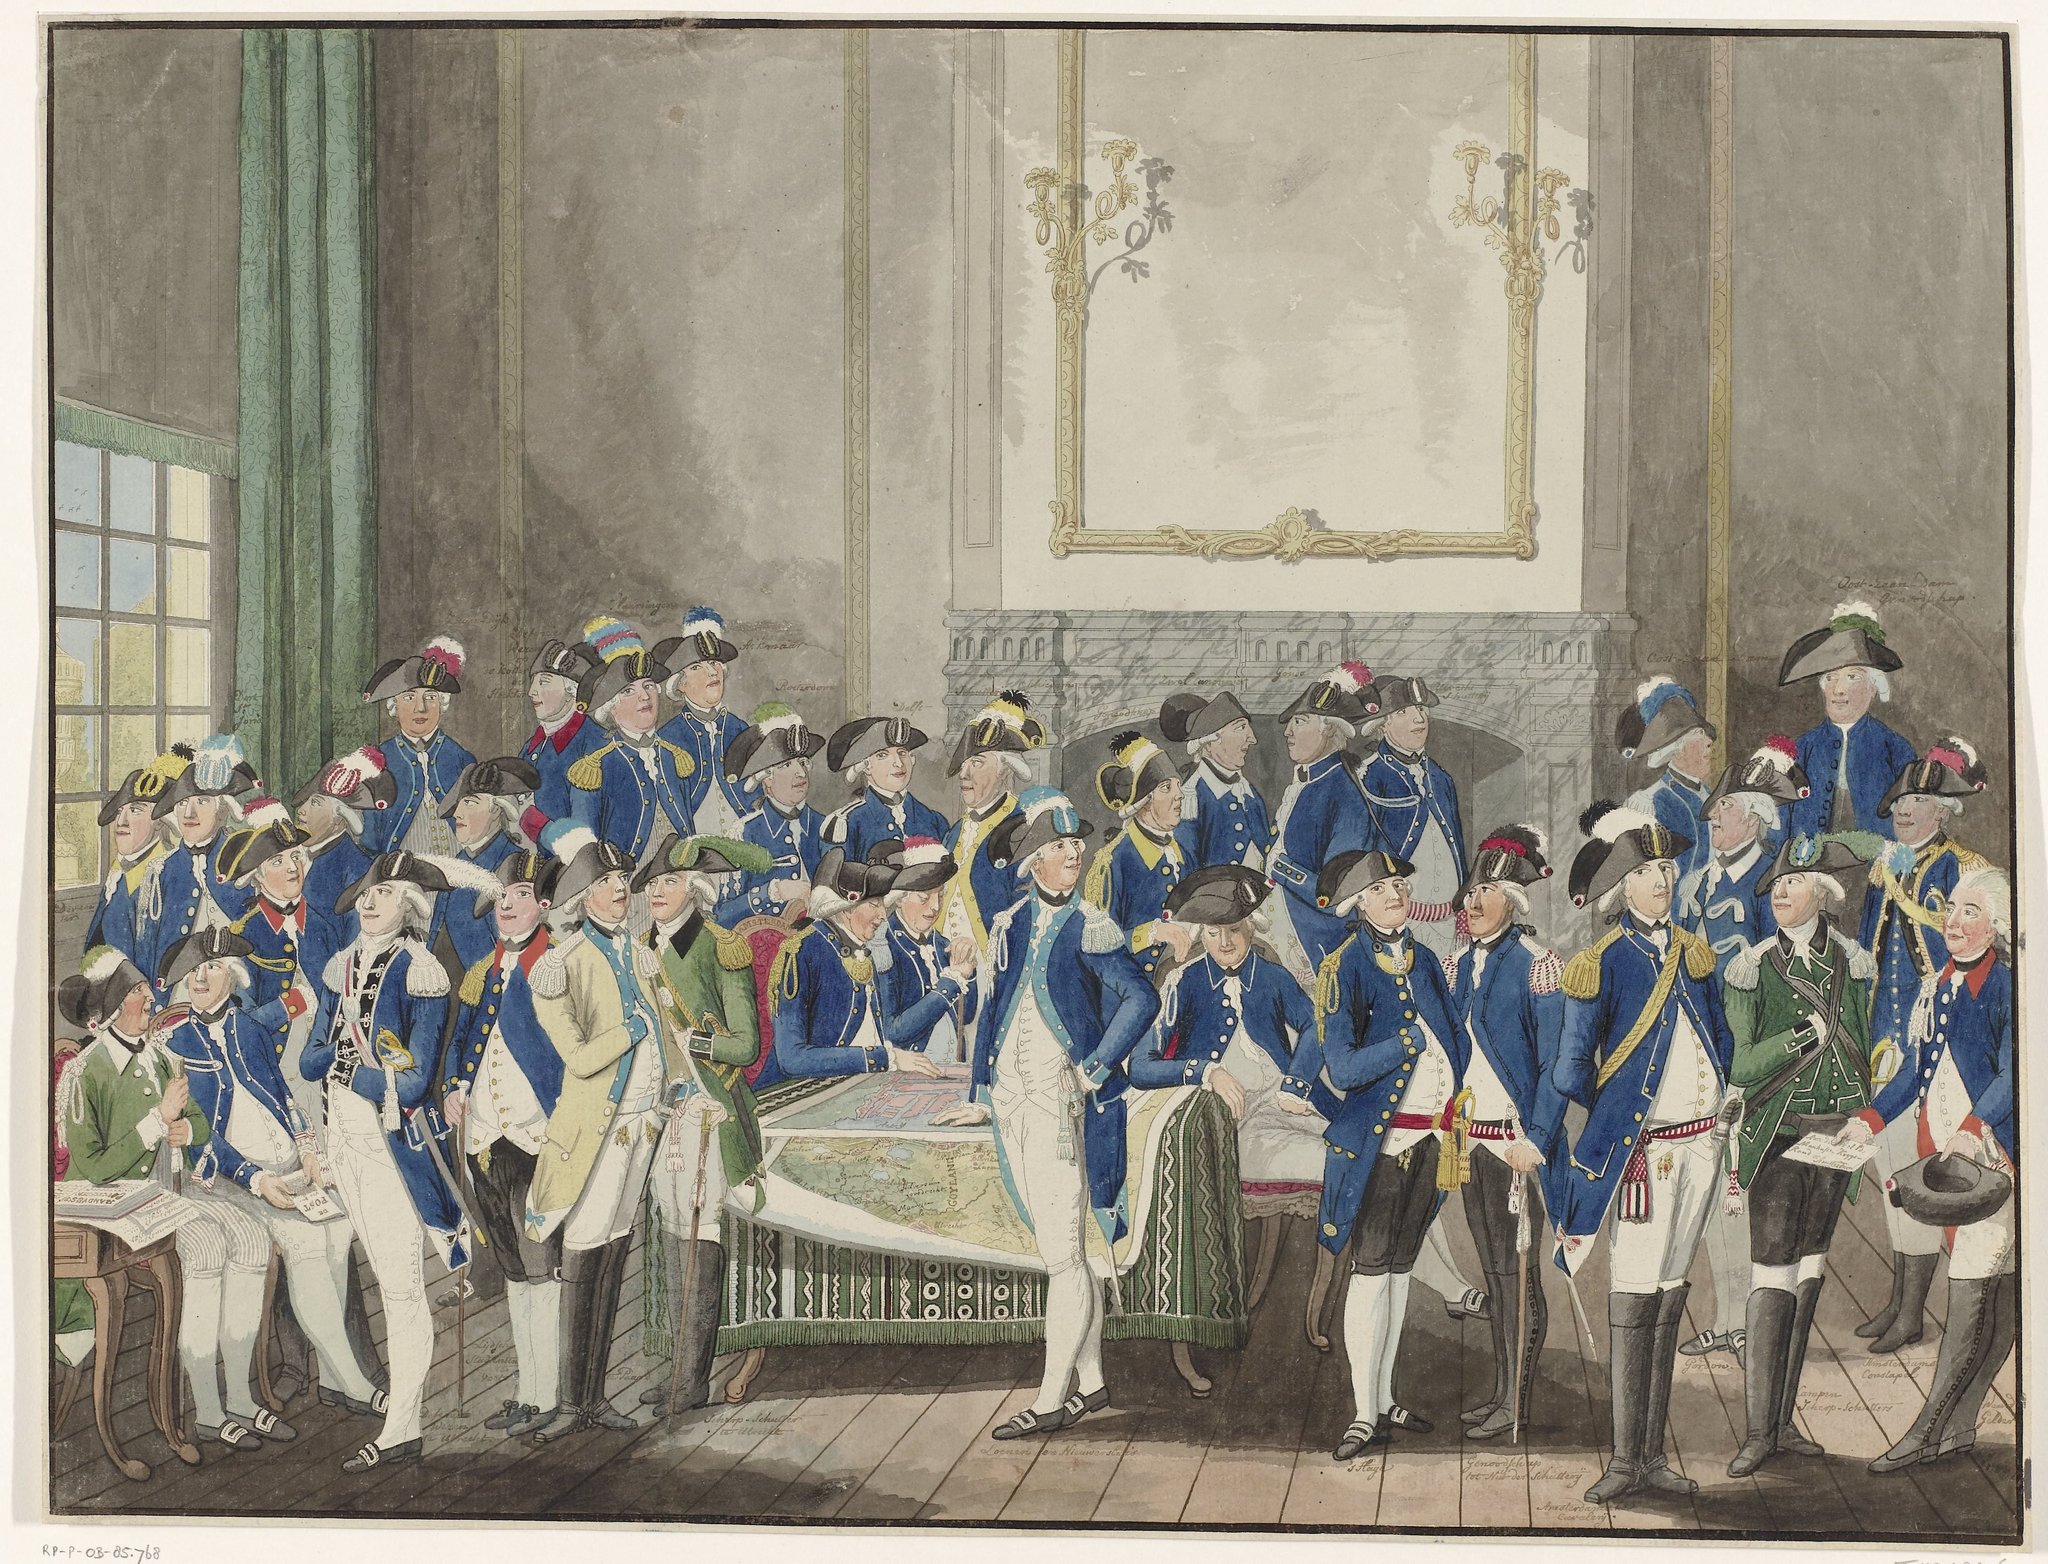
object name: costume print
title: Zaal met schutters in verschillende monteringen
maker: Anonymous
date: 1787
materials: paper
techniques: etching, hand coloring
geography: northern netherlands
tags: (military) uniforms (+ citizen soldiery, civil guard, citizen militia), patriots (1780-1795)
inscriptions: collector's mark: Lugt 2228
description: Zaal met 35 schutters in de verschillende monteringen (uniformen) van schutterijen en burgerkorpsen in Nederland in 1787. Op een tafel liggen kaarten die worden bestudeerd. Tegen de achterwand een spiegellijst. Bij alle personen staan de namen van hun korpsen geschreven.